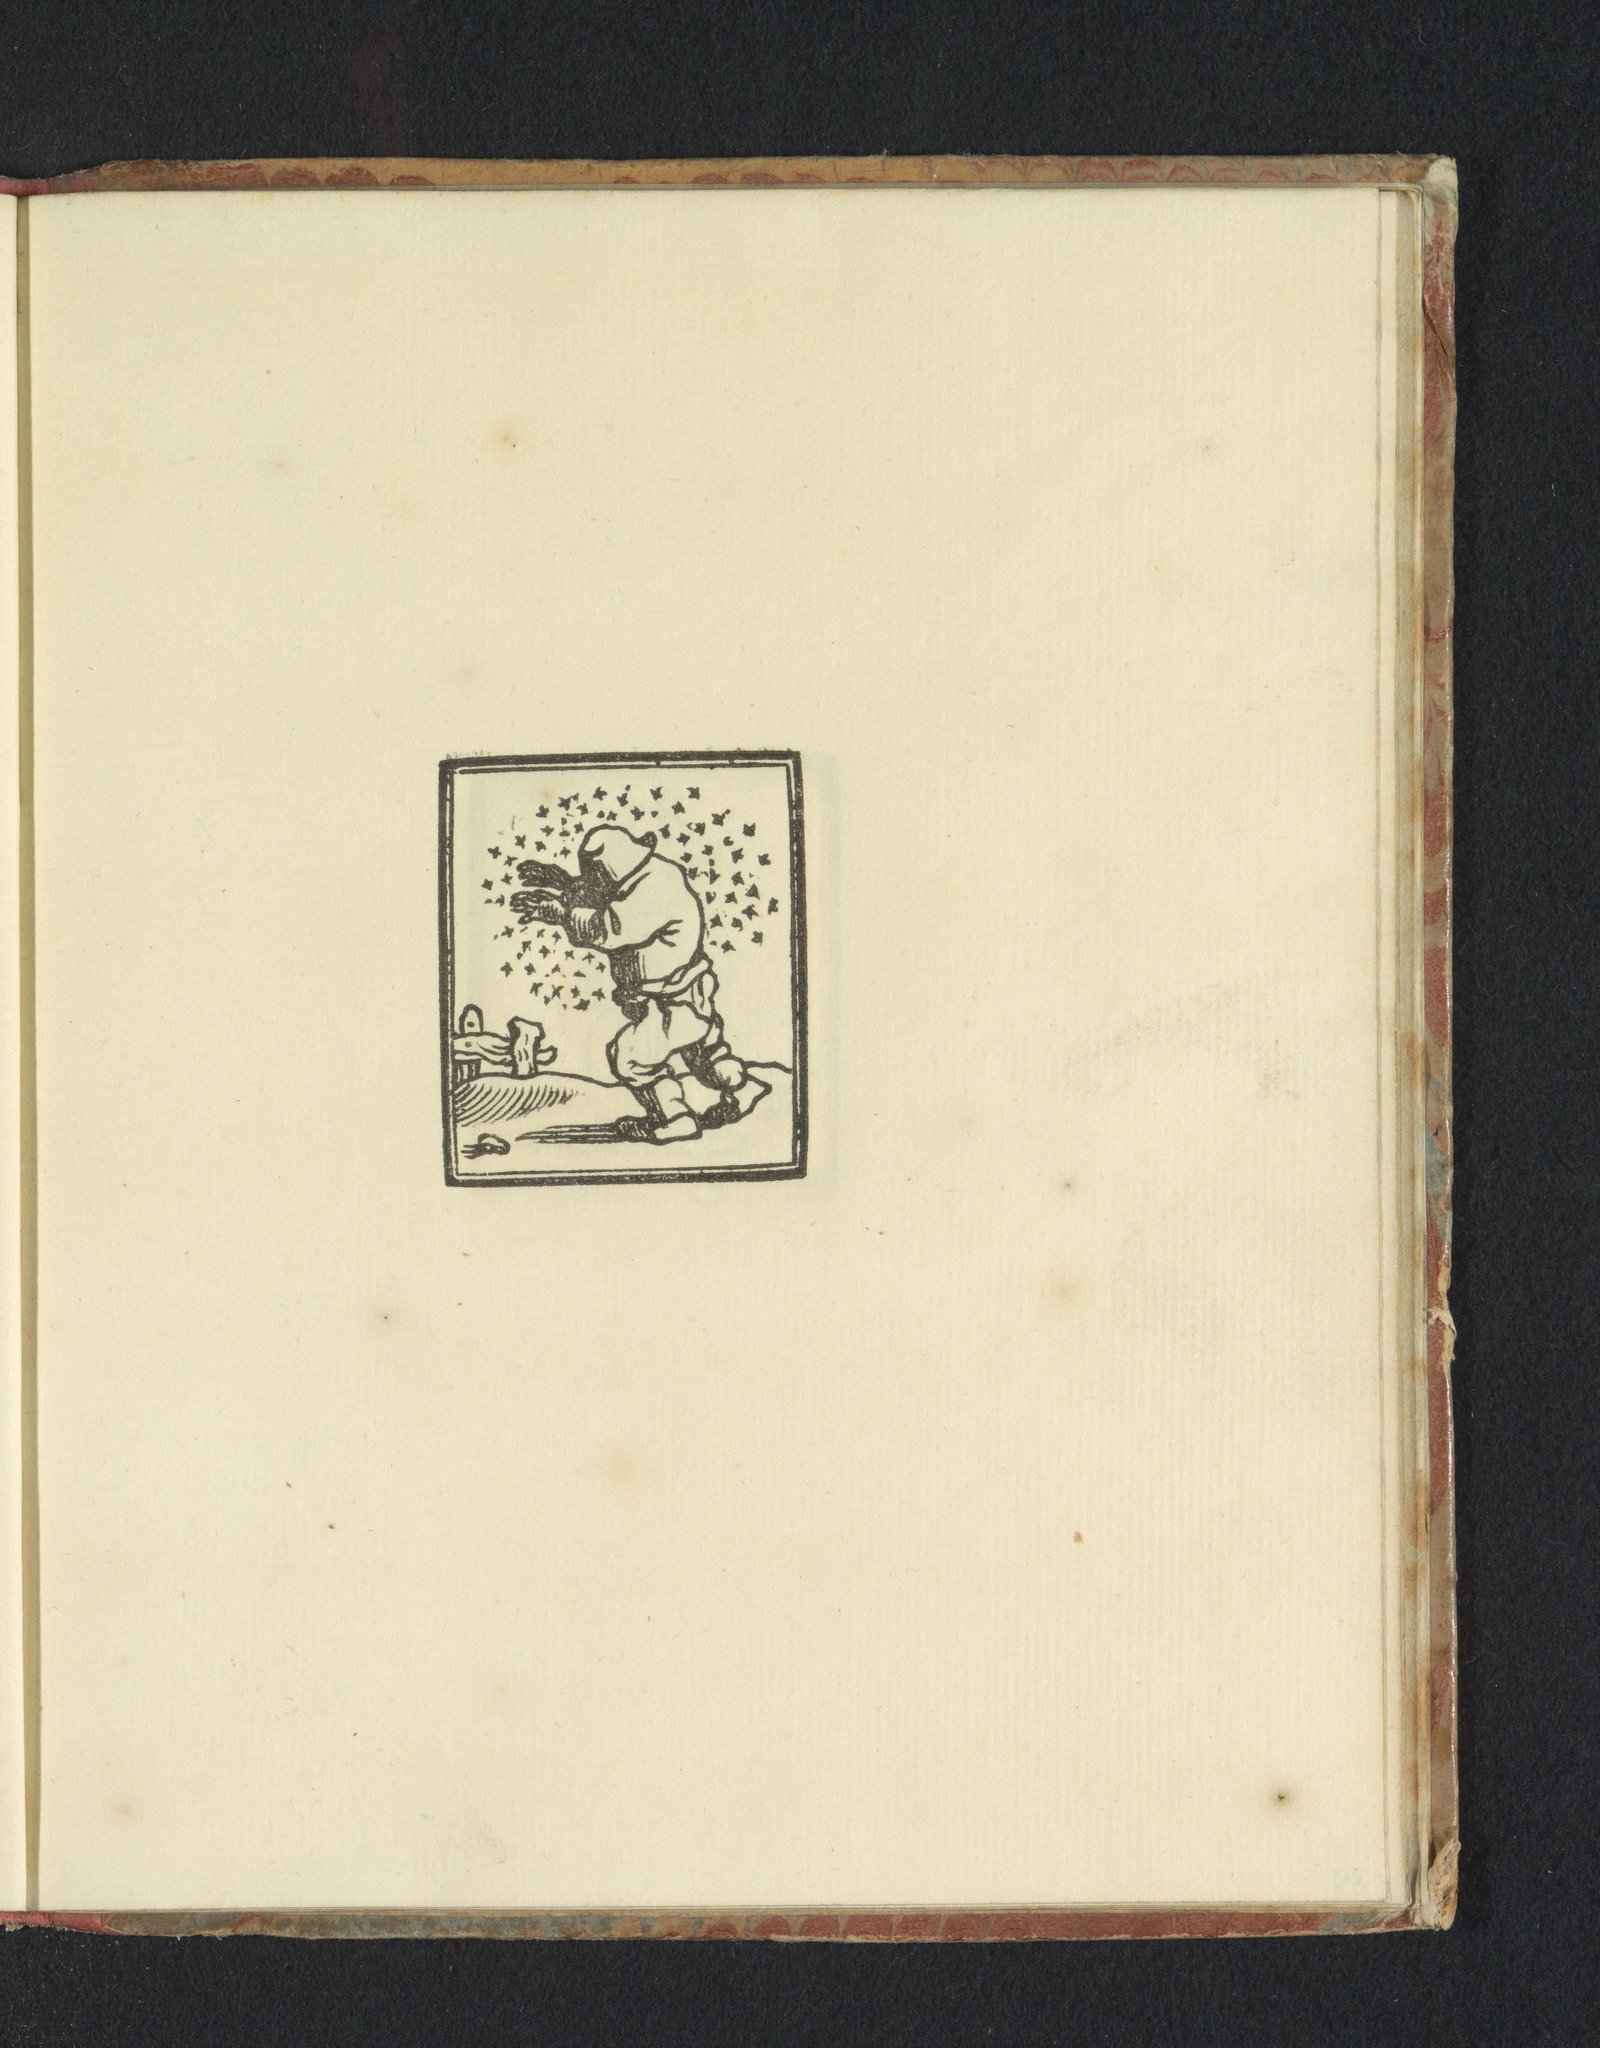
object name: print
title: Manneke-mug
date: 1731-1732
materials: paper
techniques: woodcut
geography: haarlem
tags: caricatures (human types)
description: Koddige figuur, in het onderschrift in de overzichtsprent draagt deze figuur de naam: Manneke-mug. Onderdeel van het boekje: XXXVI. aartige figuuren, geinventeert door Izaak van Ostade tot Haarlem [1731-1732].